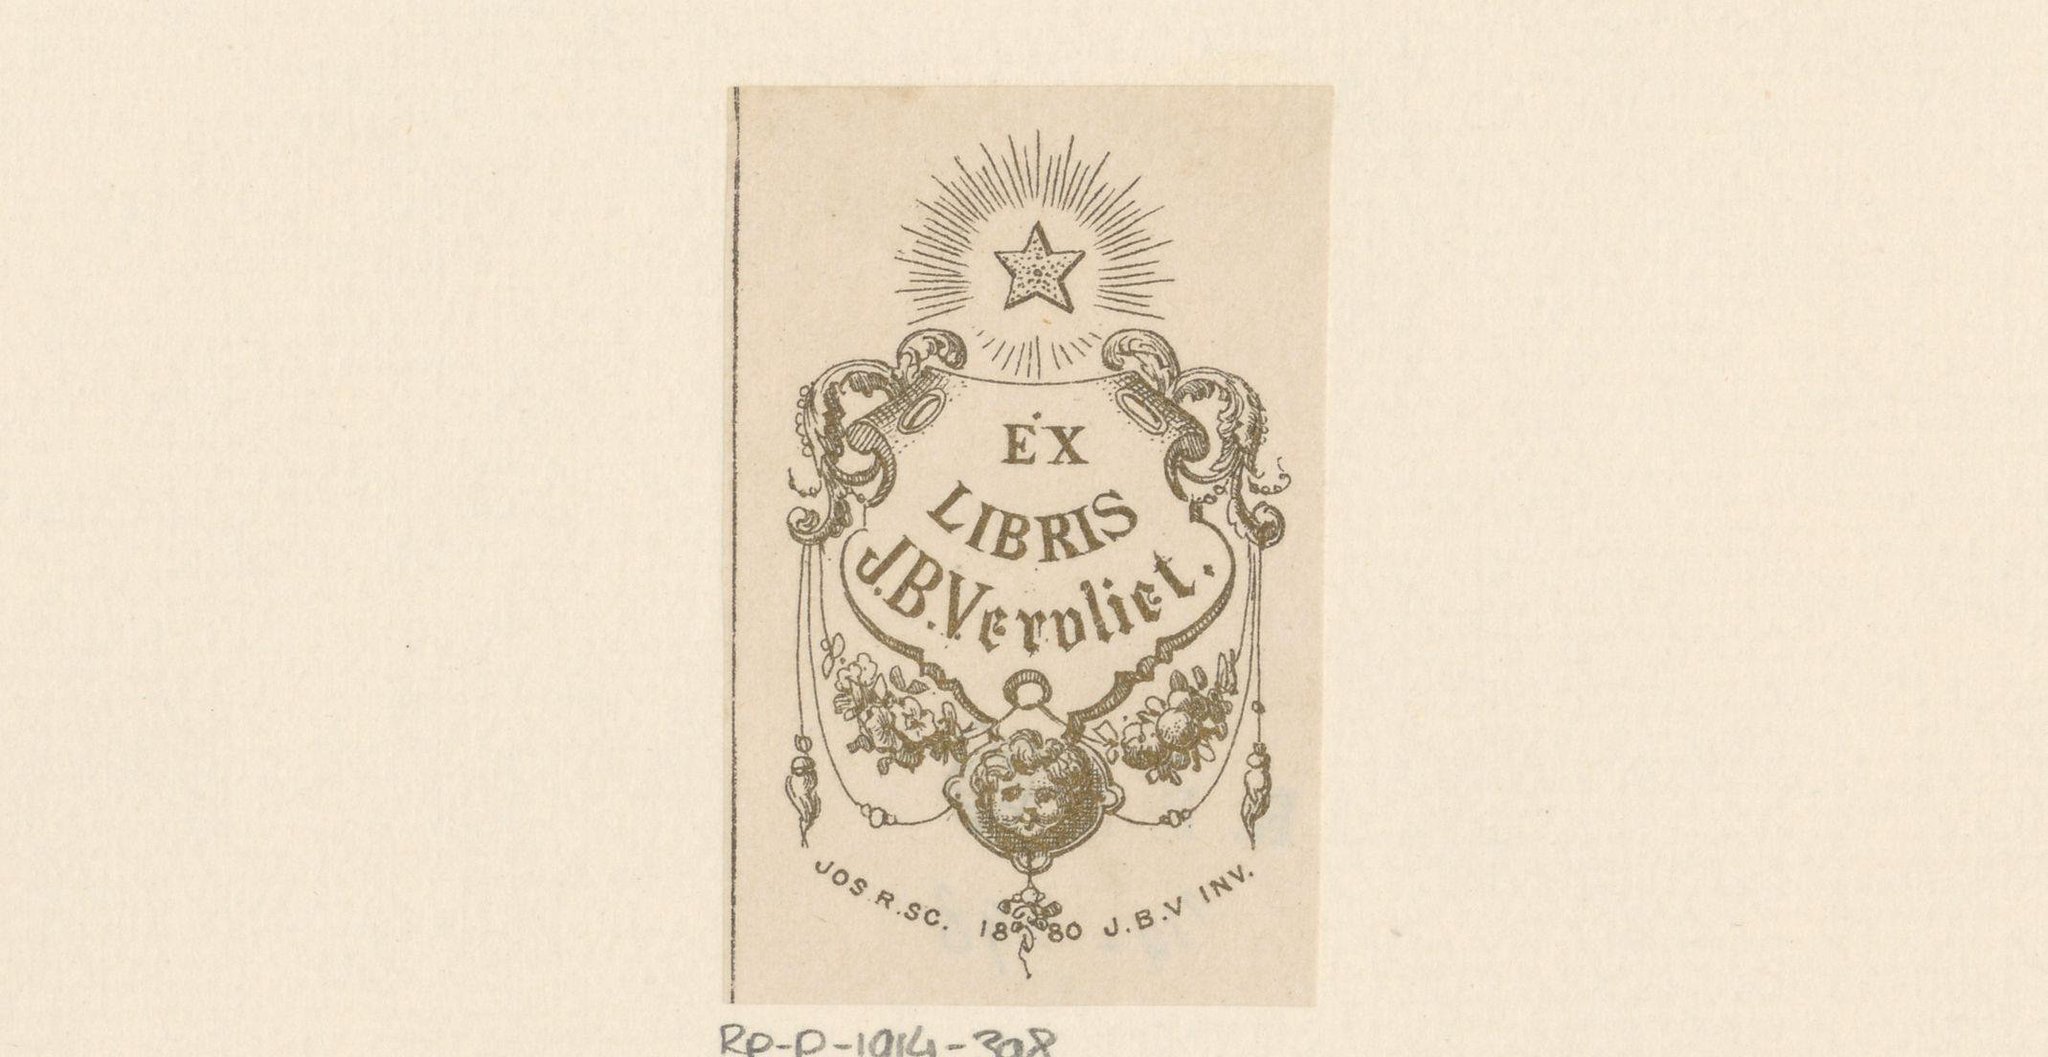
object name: photomechanical print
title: Ex libris van J.B. Vervliet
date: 1880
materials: paper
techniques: printing block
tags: jan baptist vervliet, ornament ~ cartouche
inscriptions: collector's mark: Lugt 2760, collector's mark: Lugt 2233